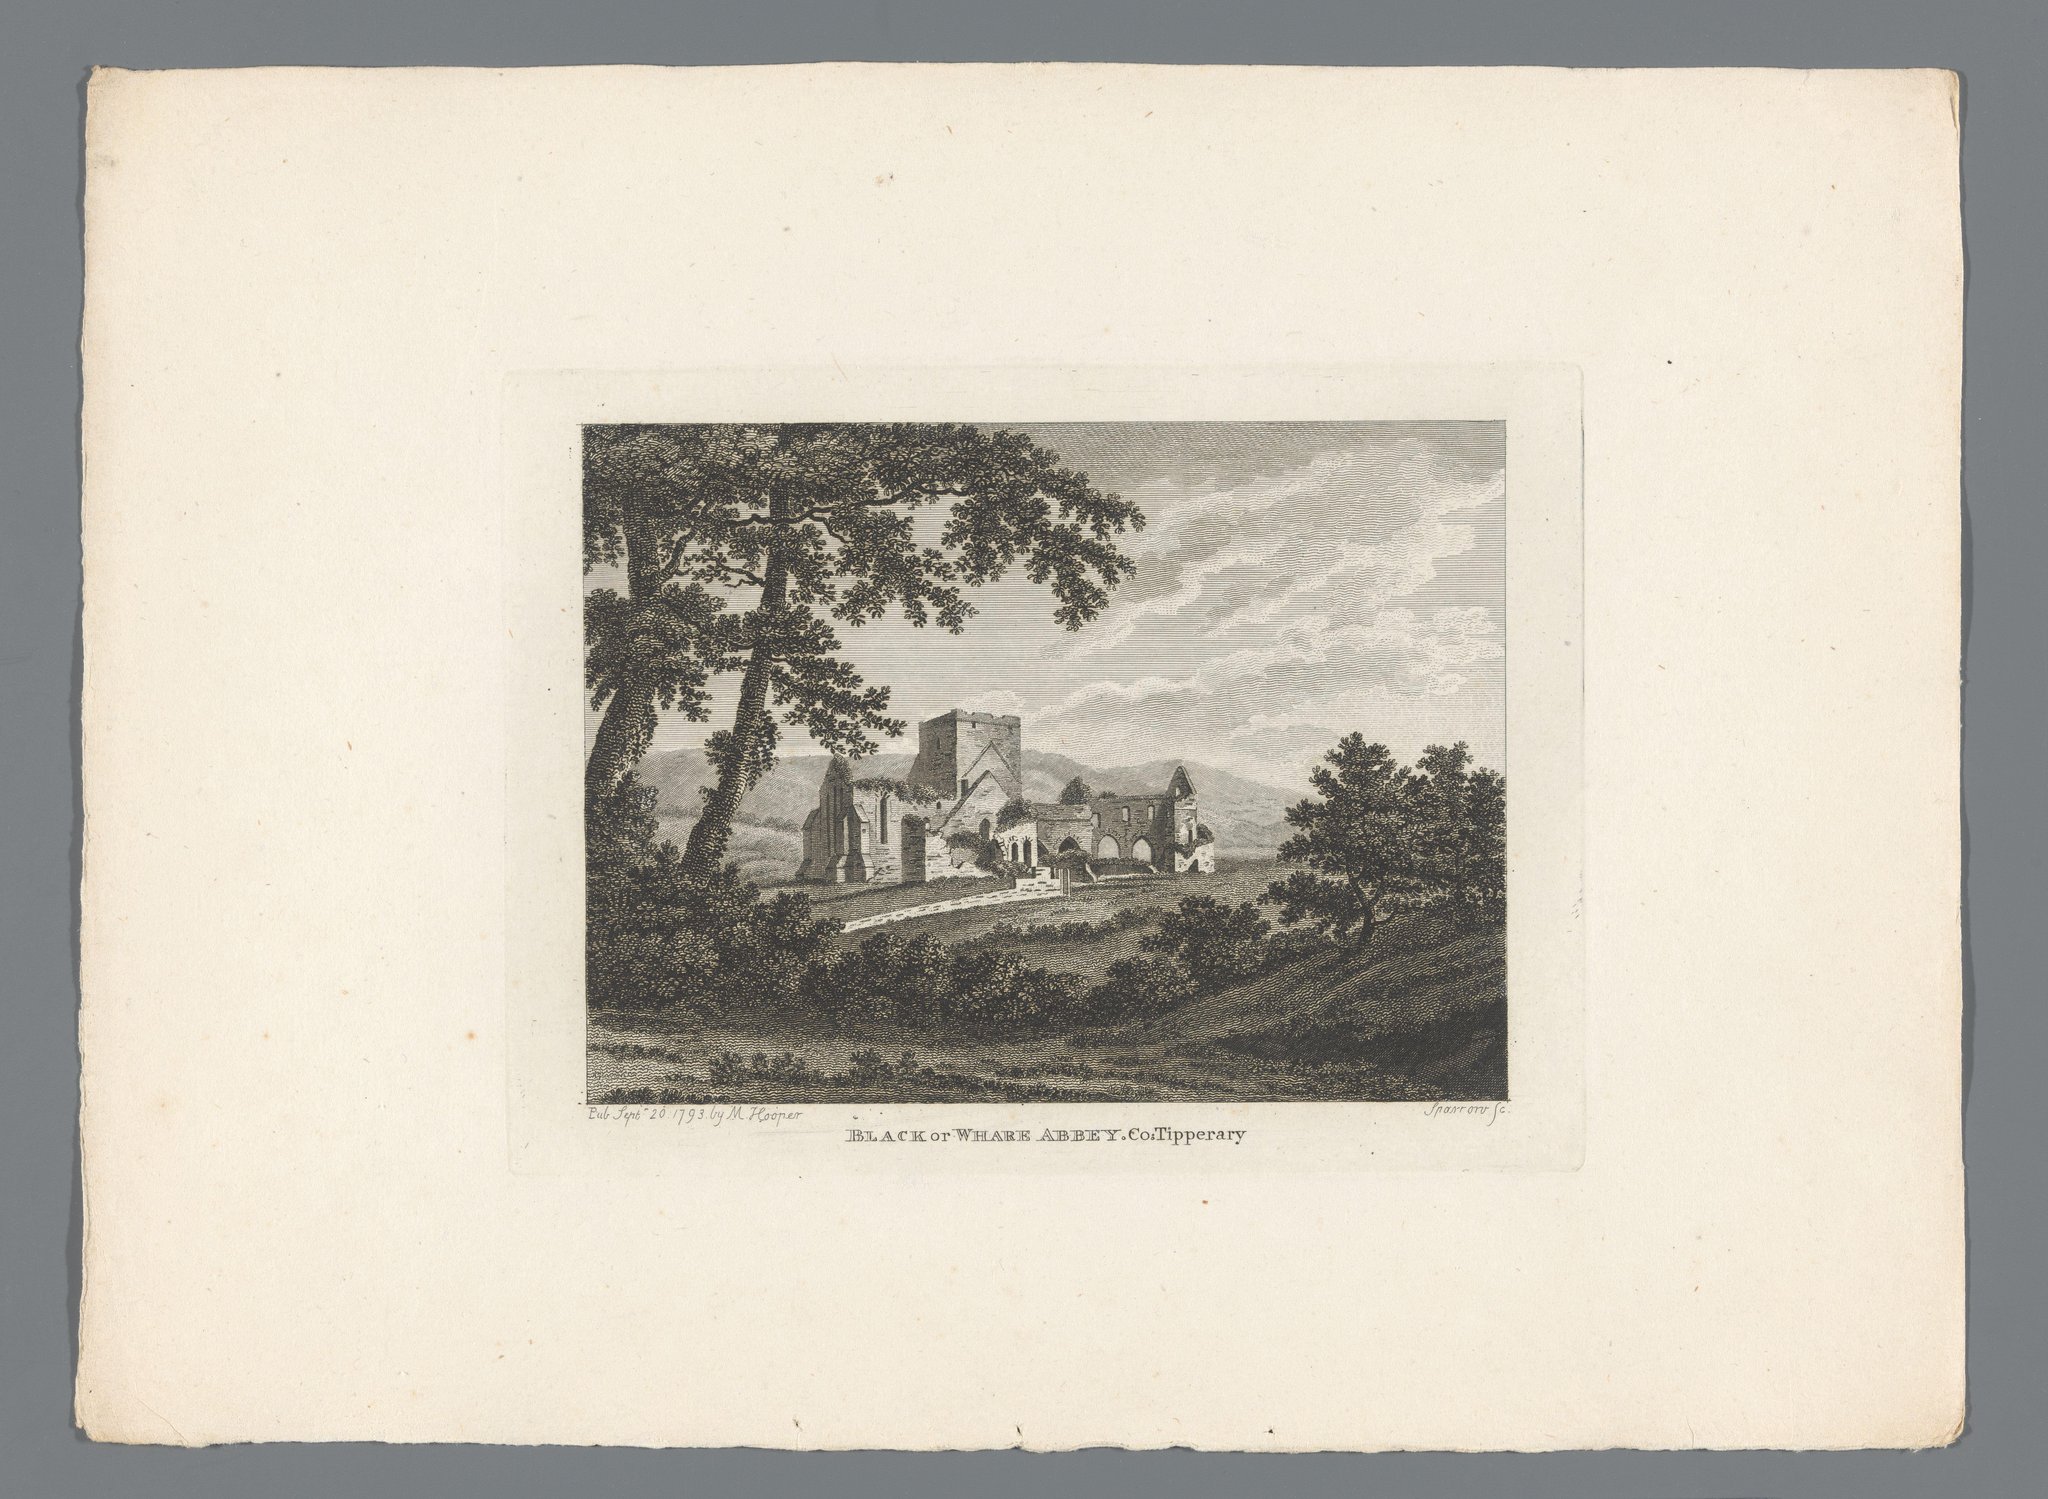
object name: book illustration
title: Black or whare abbey. Co.Tipperary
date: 1793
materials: paper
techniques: etching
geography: london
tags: abbey, monastery, convent ~ roman catholic church, landscape with ruins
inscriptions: date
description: Prent verschenen in: Grose, Francis. The antiquities of Ireland. Londen: S. Hooper, 1795, dl. 2.